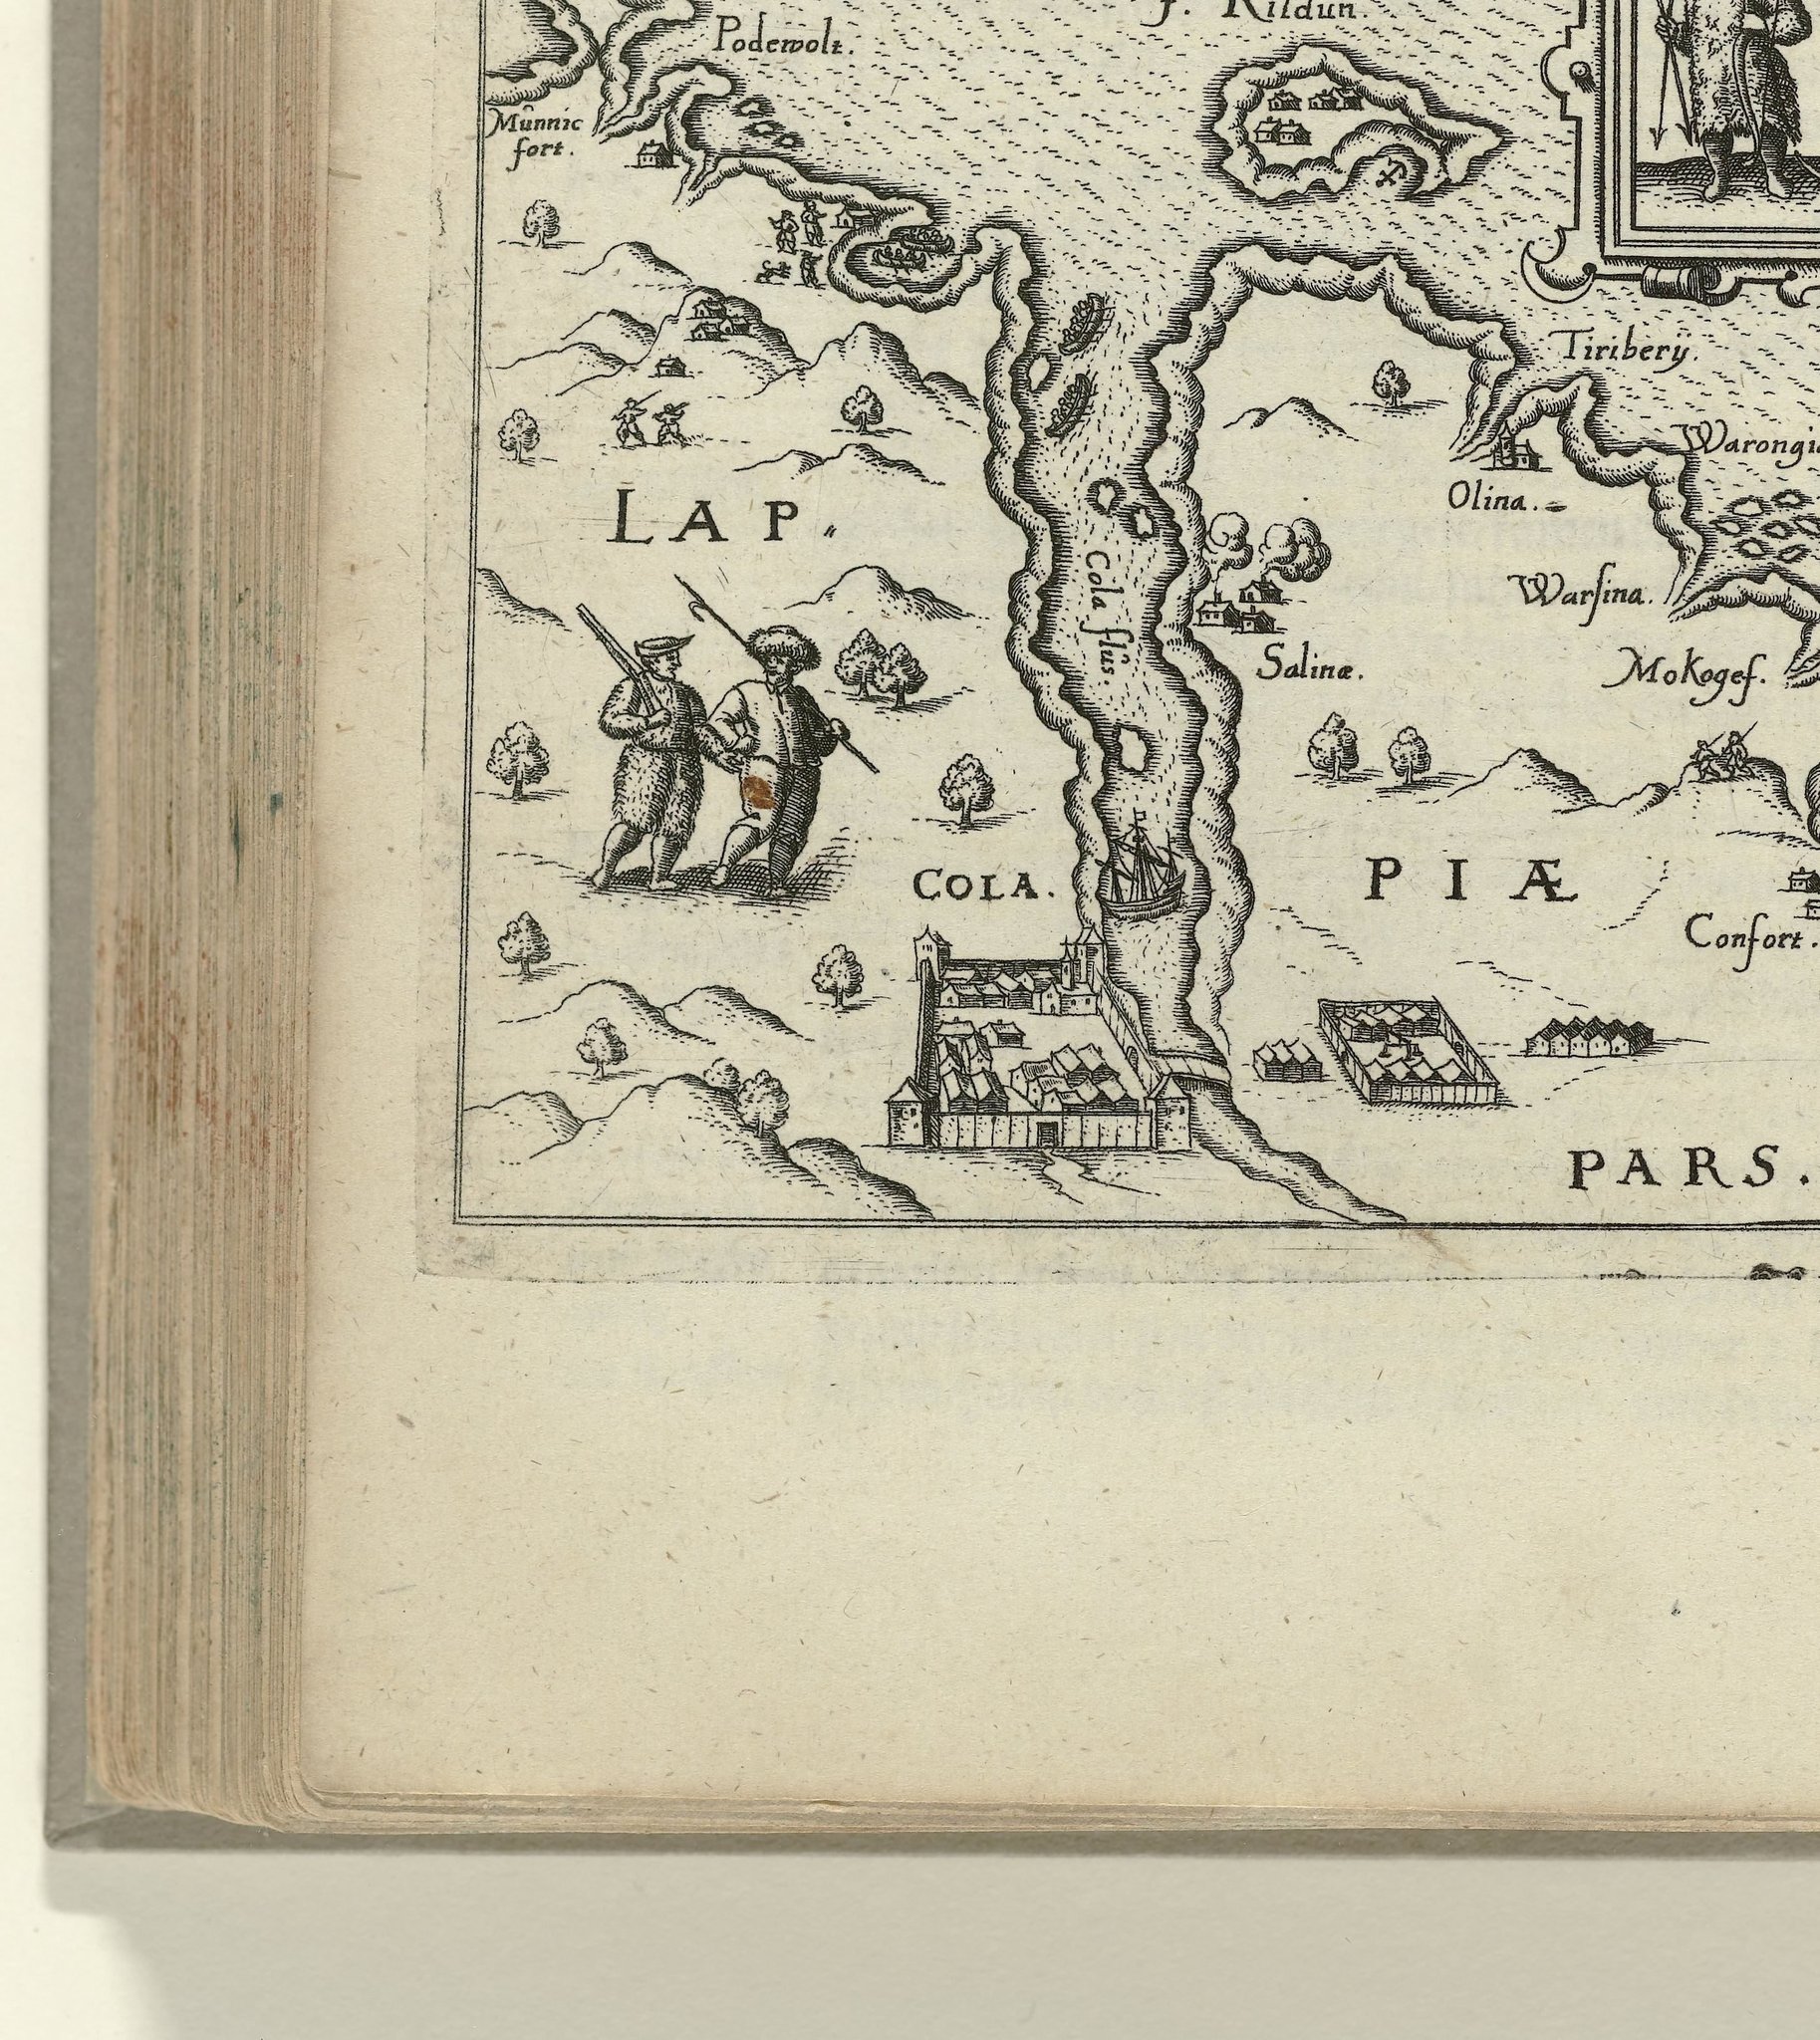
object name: print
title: Kaart van de Russische kust met de stad Kola en het eiland Kildin, 1597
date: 1598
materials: paper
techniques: engraving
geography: nuremberg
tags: willem barendsz., jacob van heemskerck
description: Kaart van de Russische kust met het de plaats Kola nabij Moermansk. Rechts van de riviermonding het eiland Kildin, waar de boten aankwamen. op 25 augustus 1597. In cartouche rechtsboven drie voorbeelden van kostuums van de plaatselijke bewoners. Tegenover pagina 140 in: 'Warhafftige Relation. Der dreyen newen unerhörten seltzamen Schiffart so die Holländischen und Seeländischen Schiff....Anno 1594, 1595 und 1596 verricht' (1598).